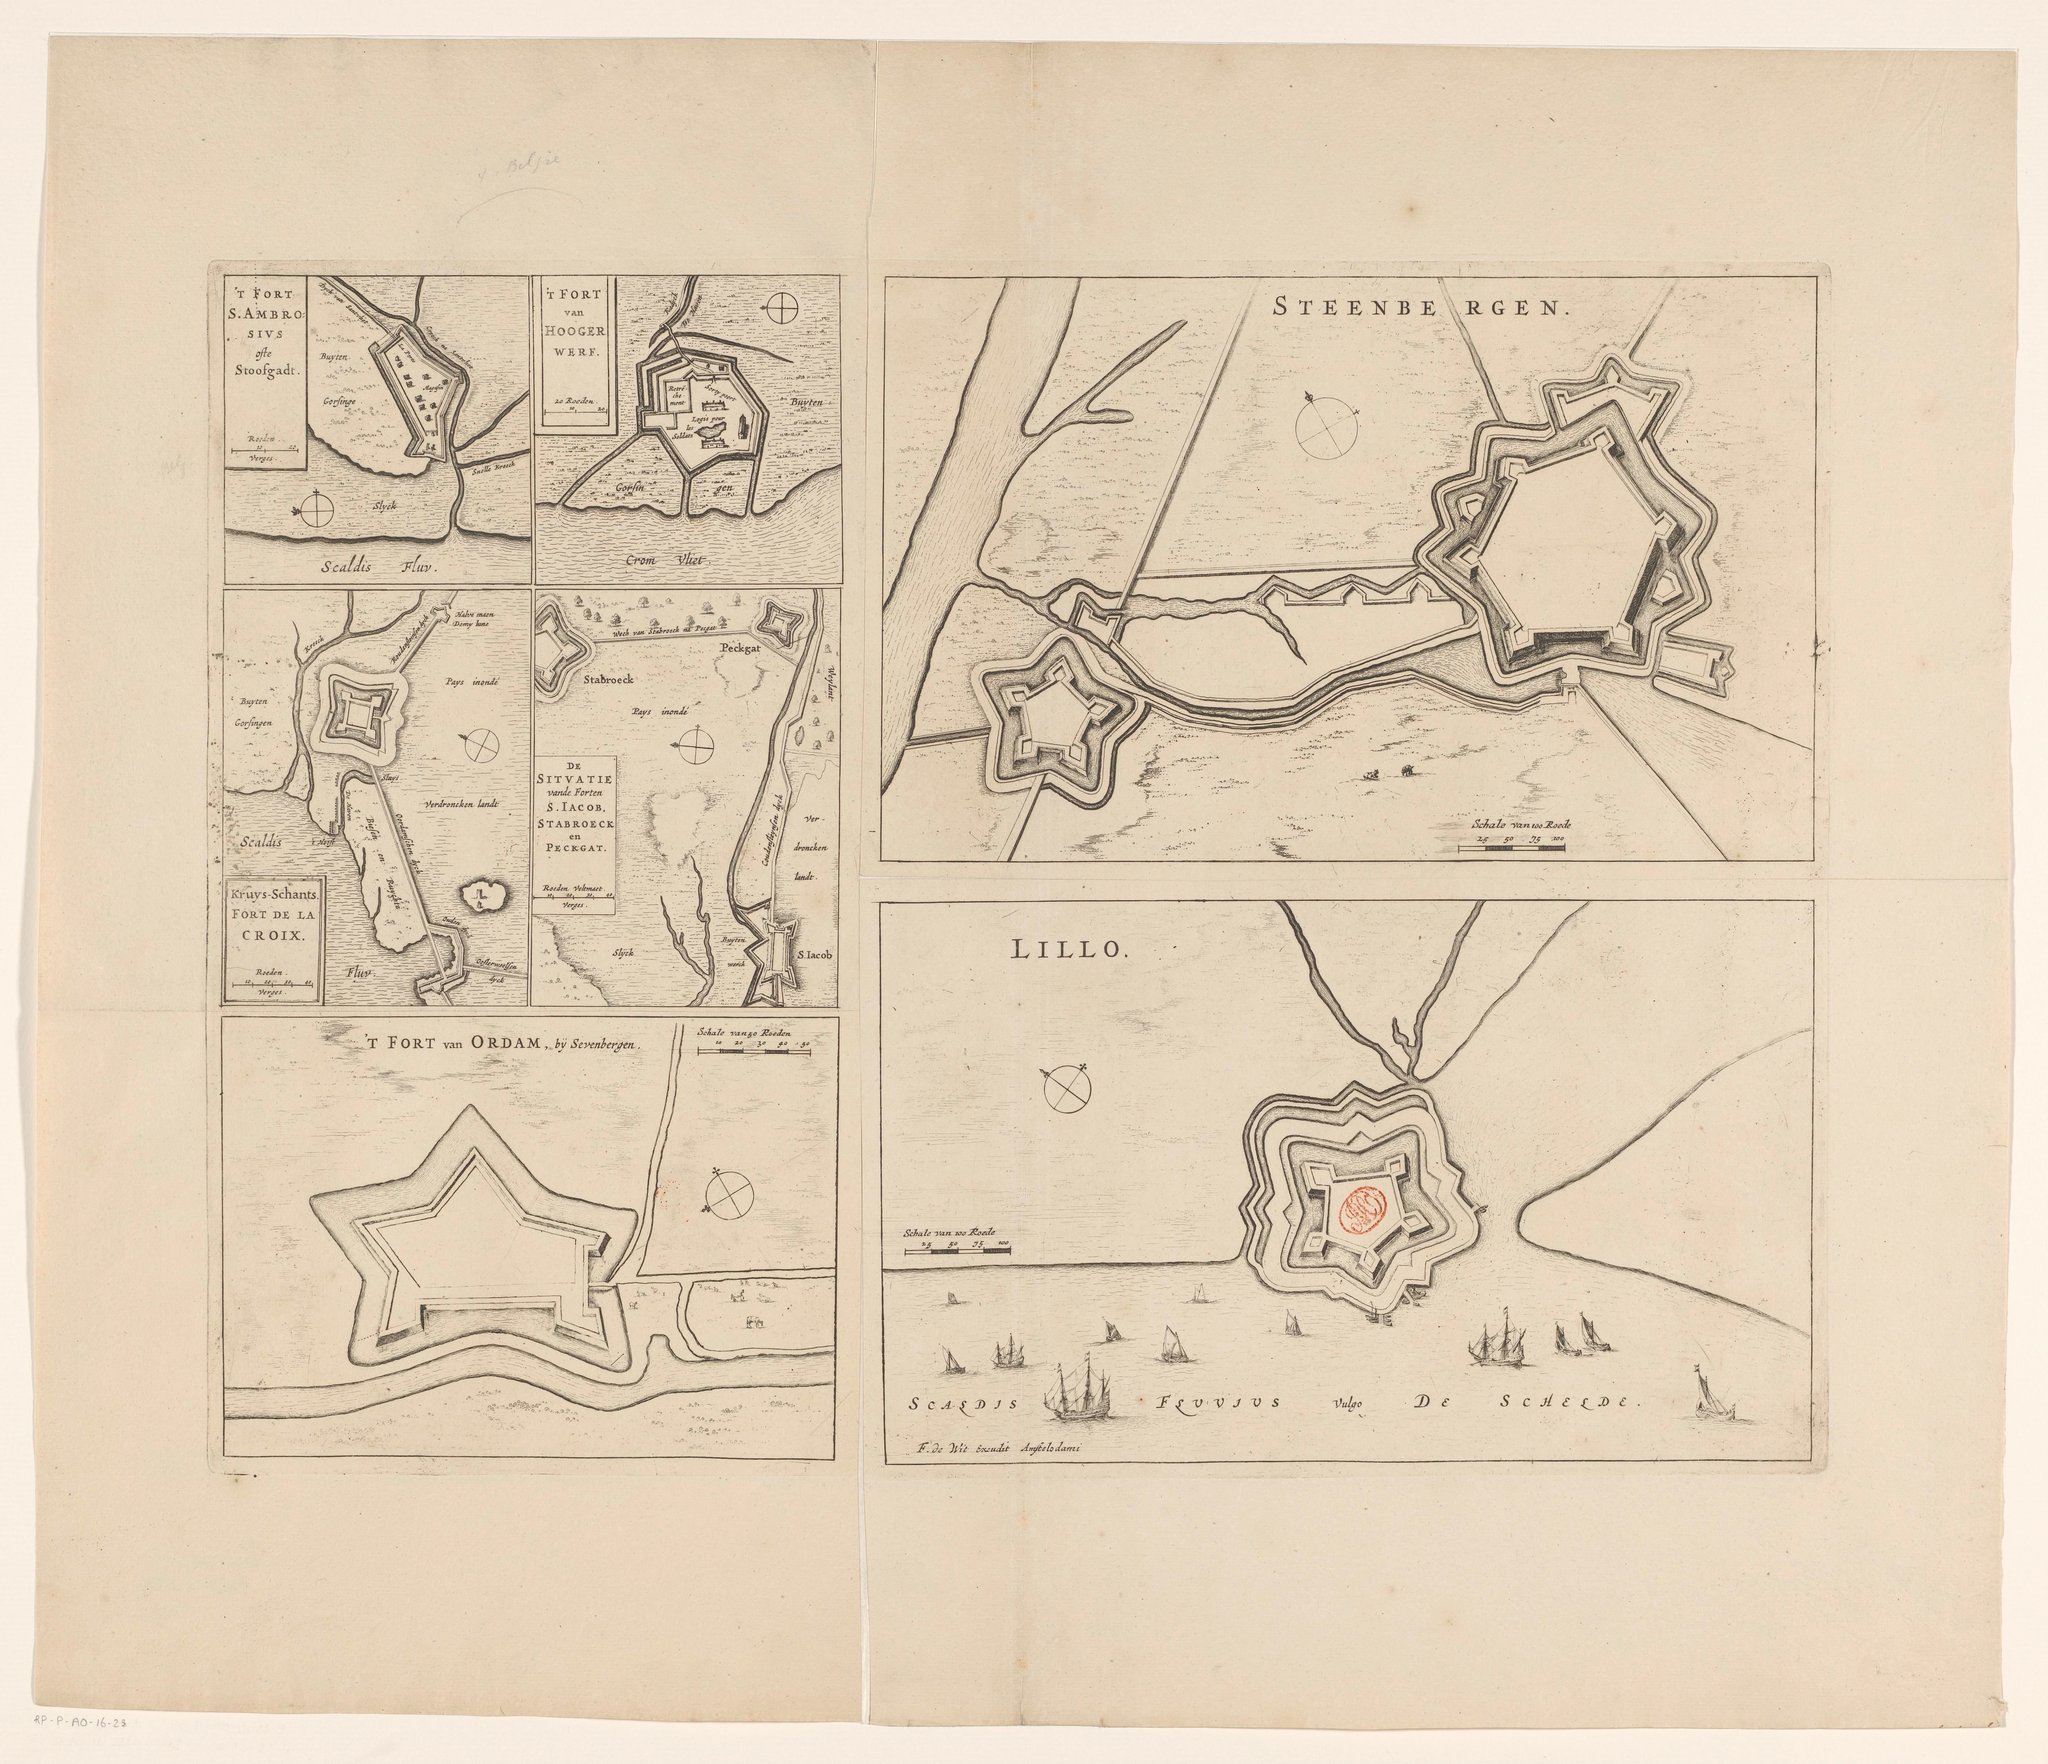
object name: area plan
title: Steenbergen / Lillo / 't Fort S. Ambrosius / 't Fort van Hoogerwerf / Kruys-Schants. Fort de la Croix / De situatie vande Forten S. Jacob, Stabroeck en Peckgat / 't Fort van Ordam by Sevenbergen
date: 1649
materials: paper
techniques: engraving, etching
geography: amsterdam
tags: fortified city, maps of cities, zeeland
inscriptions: collector's mark: Lugt 195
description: Huidige staat van prent ook gebruikt in: Theatrum ichnographicum omnium urbium et praecipuorum oppidorum Belgicarum XVII Provinciarum (…). Amsterdam: Frederik de Wit, ca. 1700-1710. Frederik de Wit heeft eerst afdrukken van de hele koperplaat gemaakt en vervolgens de plaat versneden tot drie losse koperplaten. Zowel de afdruk van de niet versneden plaat (zoals het huidige exemplaar), als afdrukken van de drie losse platen op één blad komen voor in exemplaren van de bovengenoemde publicatie. De drie losse platen zijn later in het bezit van Pieter van der Aa gekomen, en komen zodoende voor in: Aa, Pieter van der. La galerie agreable du monde (...). 66 delen. Leiden: Pieter van der Aa, 1728, dl. 16